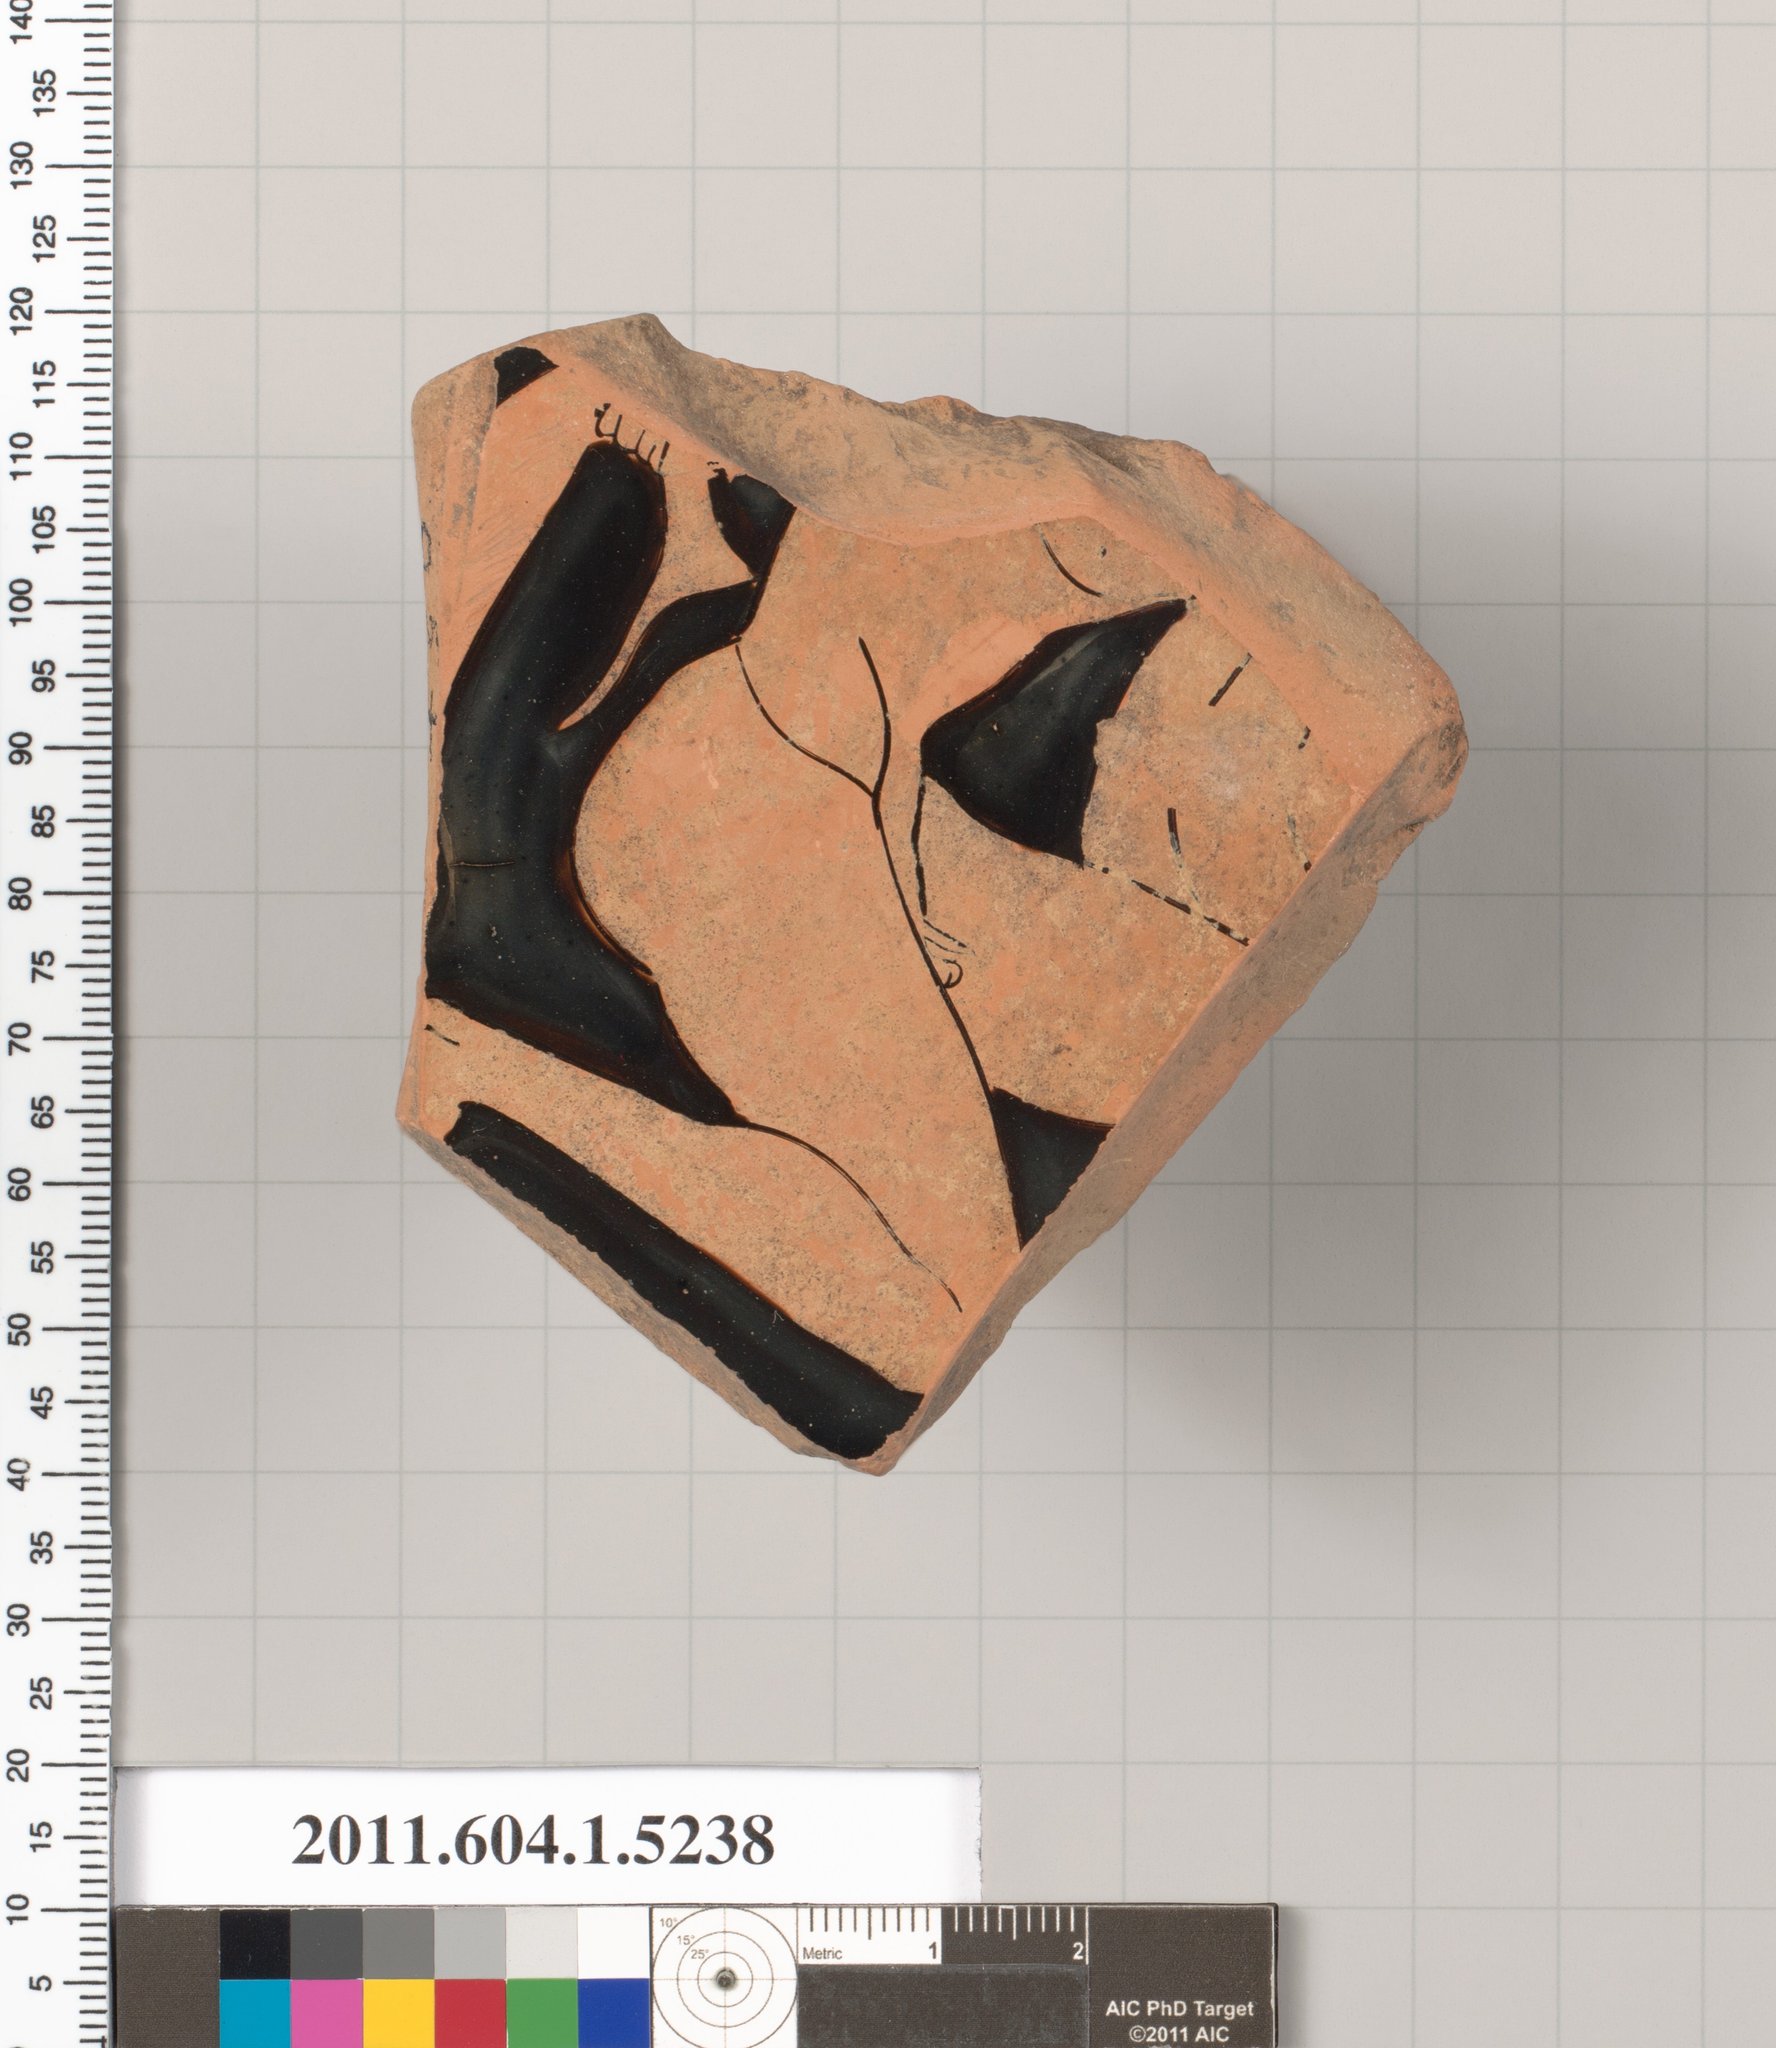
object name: kylix fragment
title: Terracotta fragment of a kylix (drinking cup)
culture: greek, attic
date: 520-500 BCE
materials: terracotta